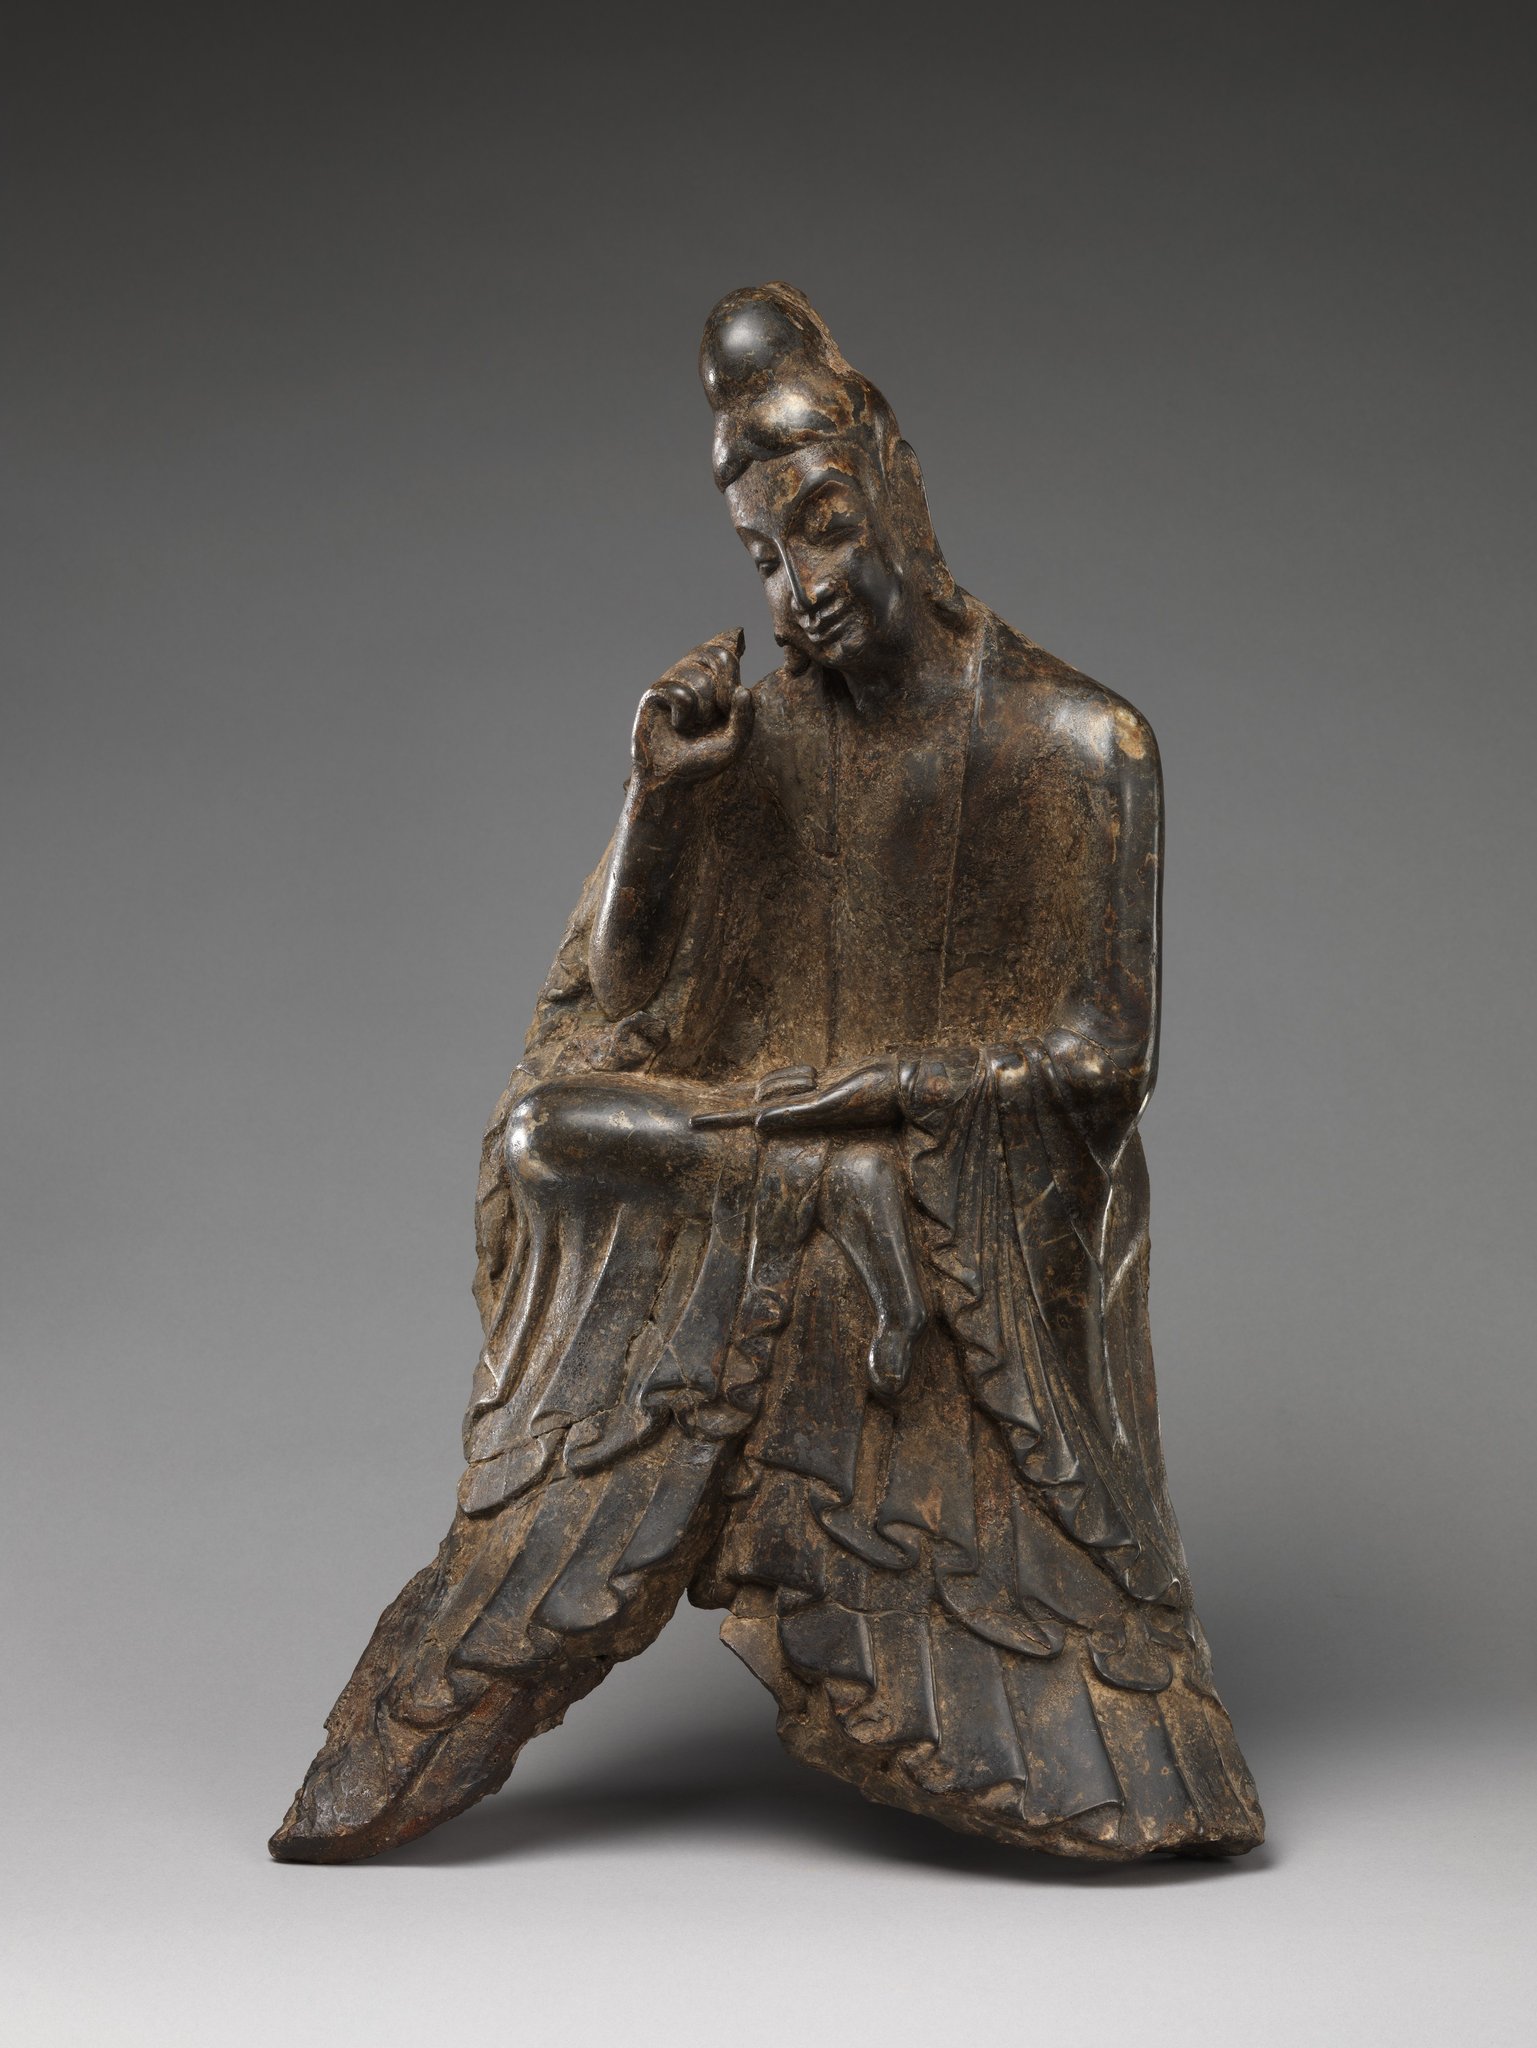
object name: figure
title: Bodhisattva in pensive pose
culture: chinese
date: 501-533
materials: limestone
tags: contemplation,bodhisattvas